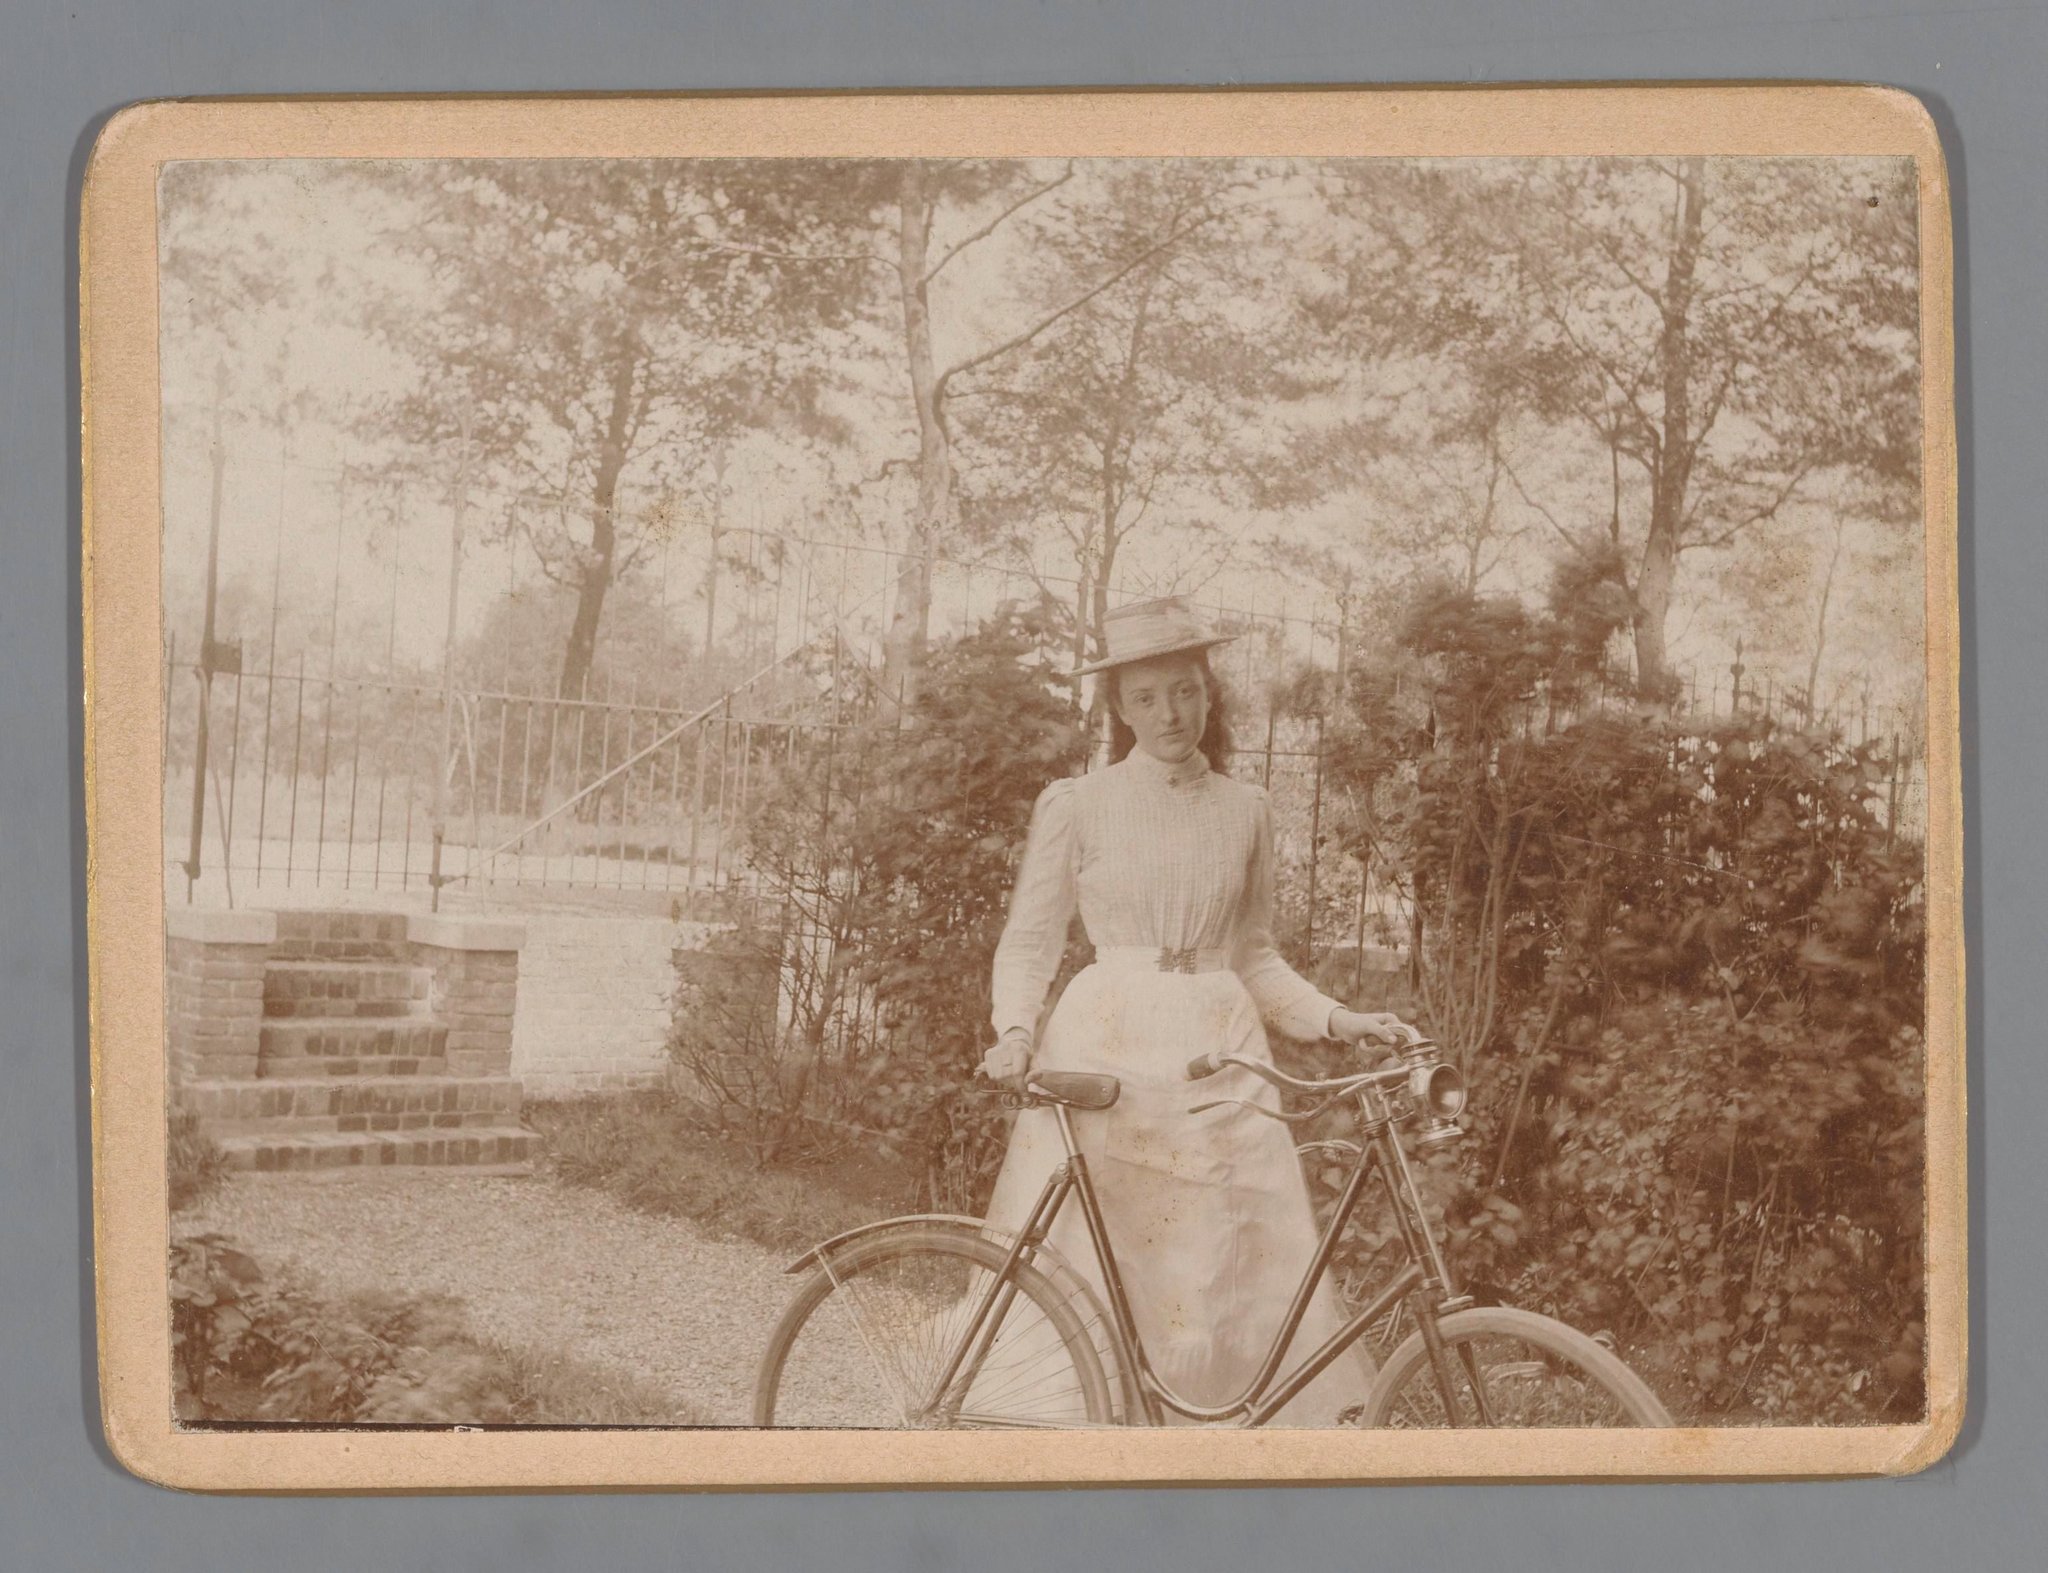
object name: photograph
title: Portret van een onbekende vrouw met een fiets in een tuin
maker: Anonymous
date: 1890-1905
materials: cardboard, photographic support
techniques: daylight paper print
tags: adult woman, garden, bicycle